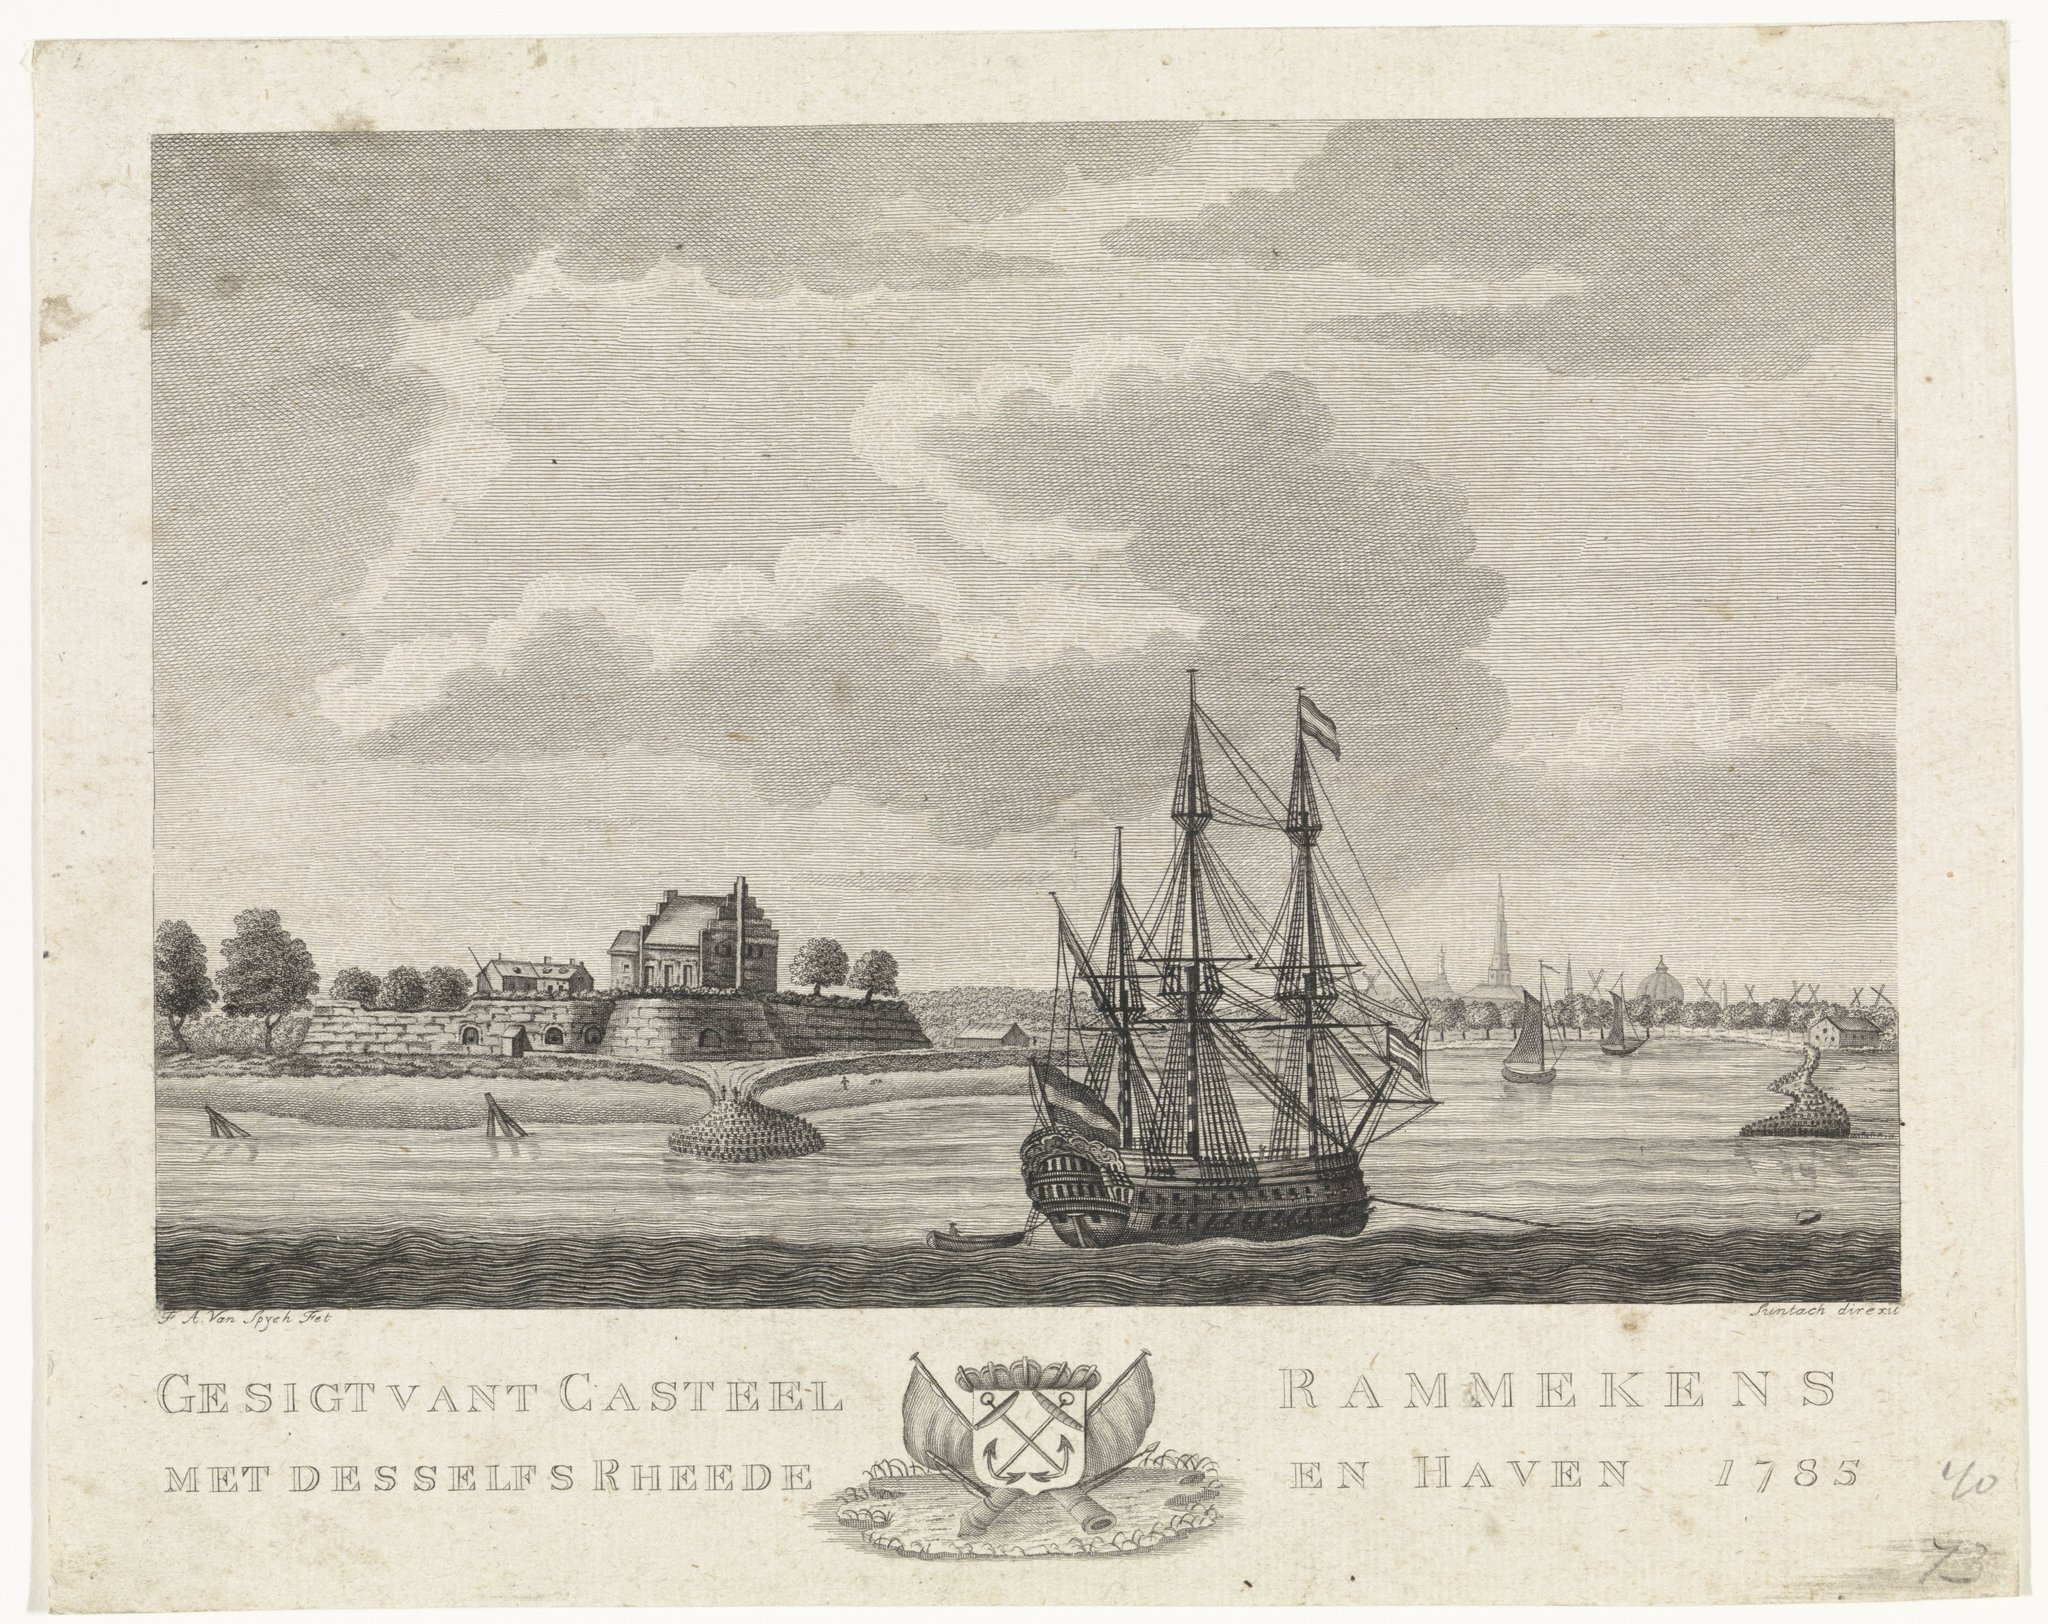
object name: print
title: Gesigt vant Casteel Rammekens met desselfs rheede en haven, 1785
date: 1785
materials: paper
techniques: etching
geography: netherlands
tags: fortress, sailing-ship, sailing-boat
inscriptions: collector's mark: Lugt 2228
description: Gezicht op Fort Rammekens met rechts de haven op Walcheren in Zeeland. Op de rede van het fort ligt een schip. Midden onder een wapenschild met twee ankers.